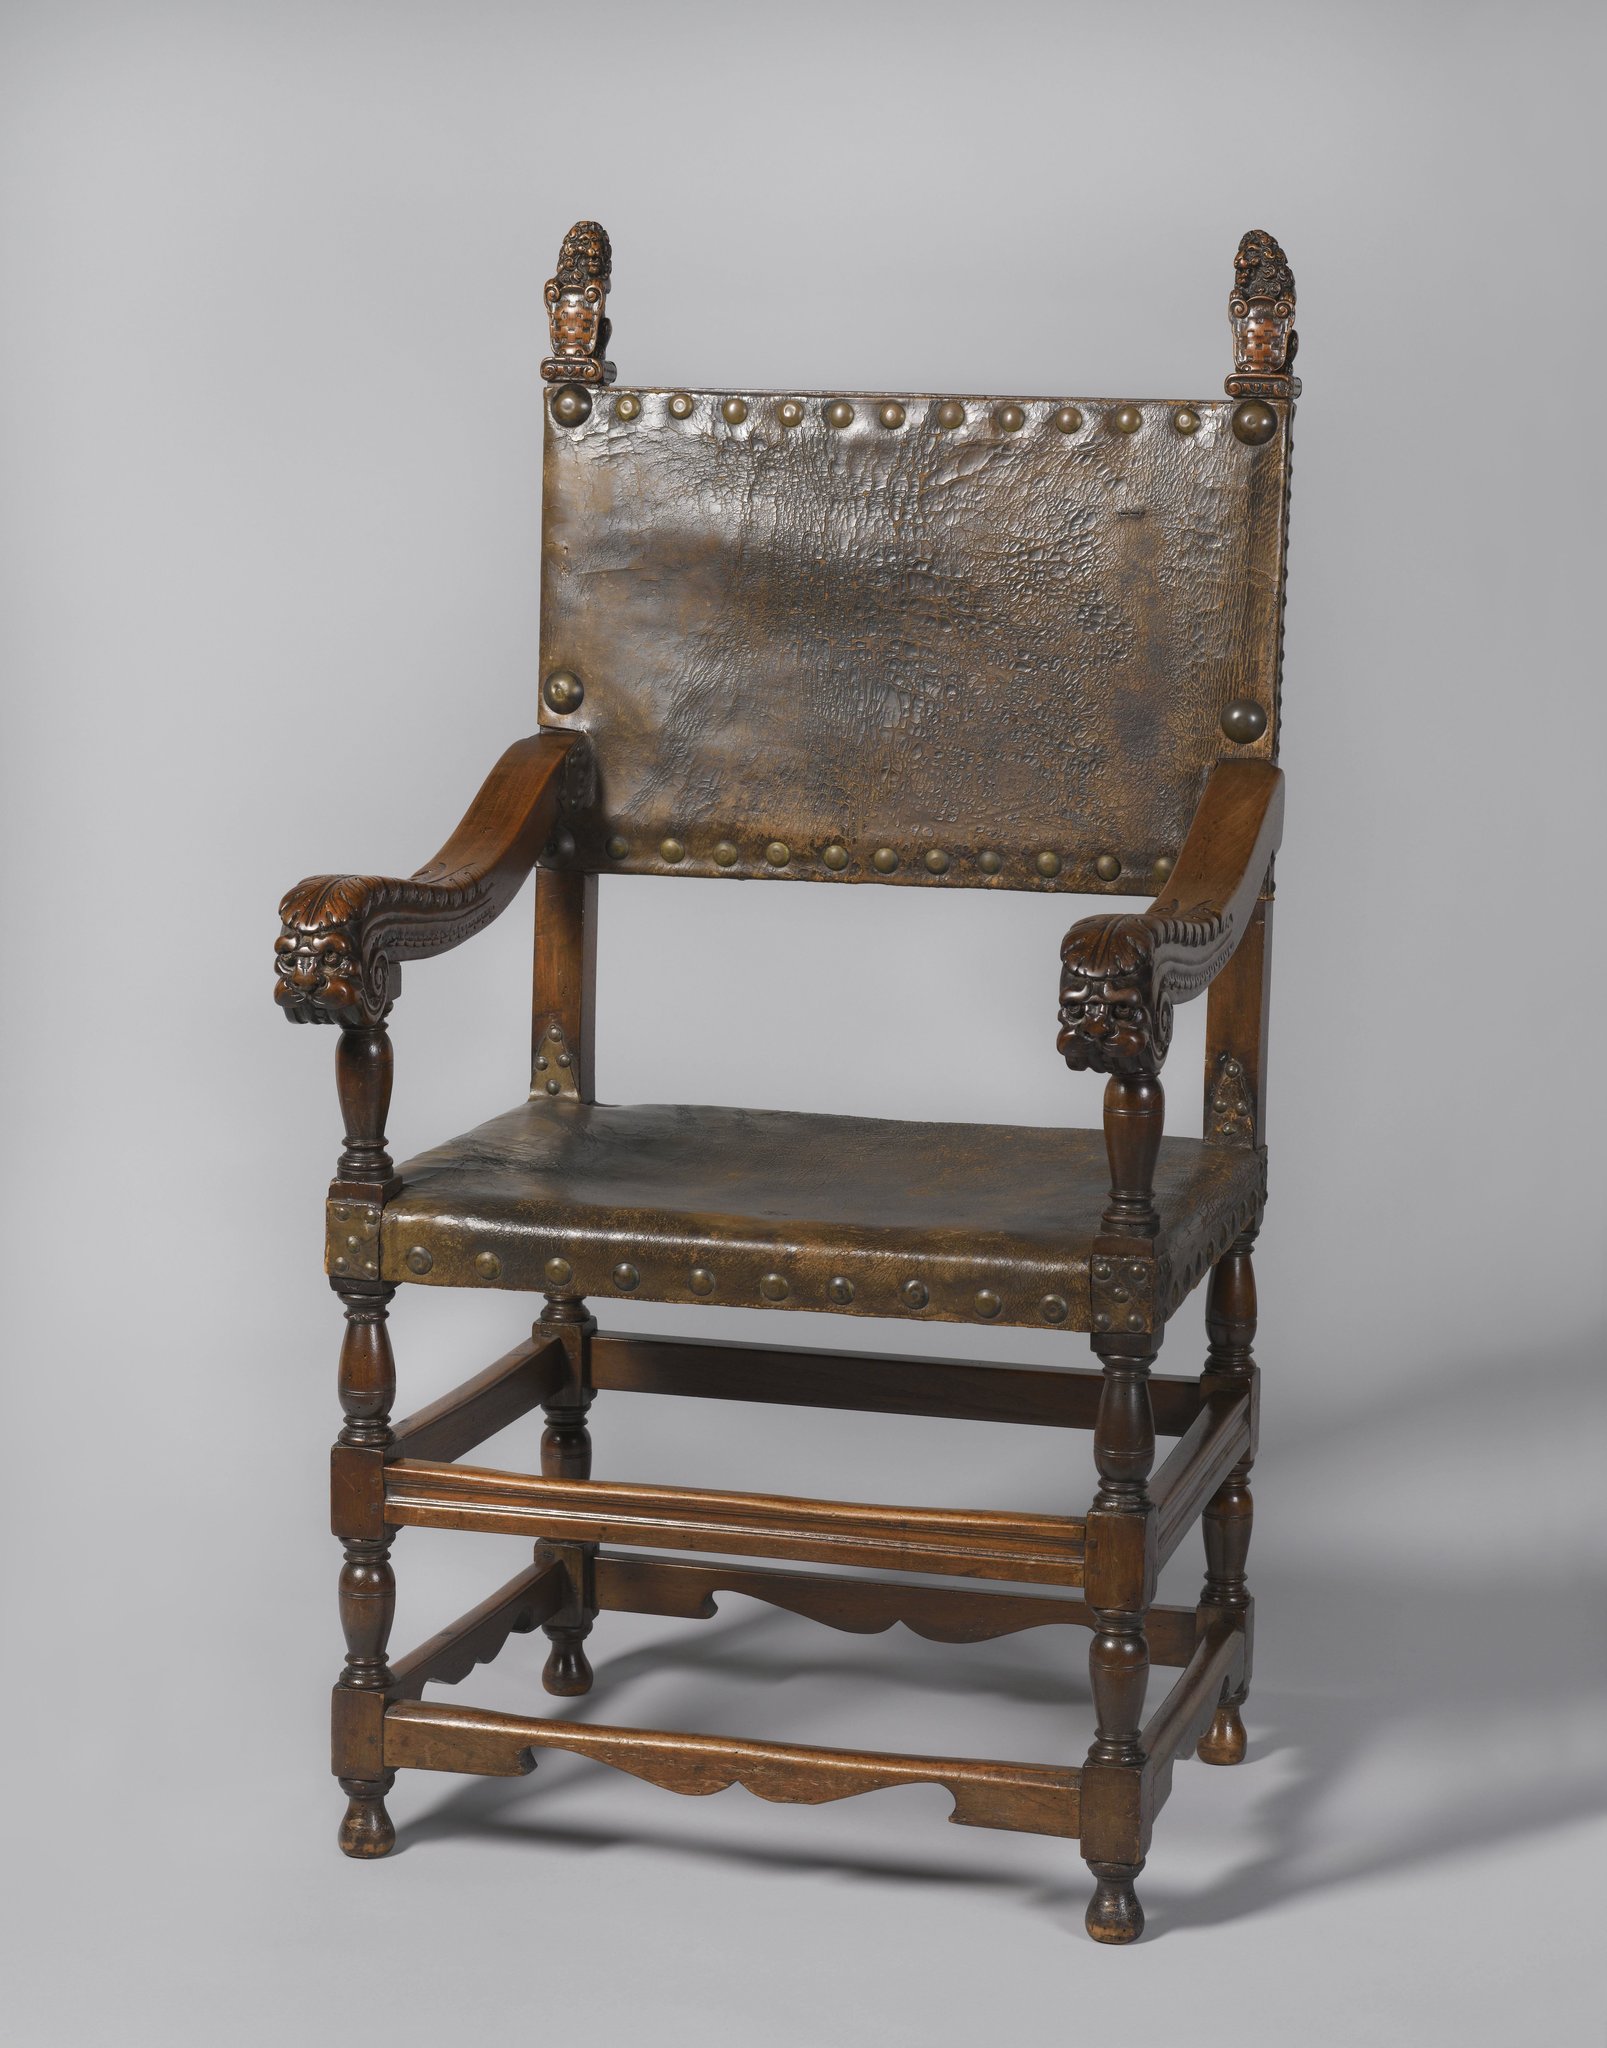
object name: furniture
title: Armstoel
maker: Anonymous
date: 1600-1625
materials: leather, wood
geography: northern netherlands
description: Armchair. Walnut, Netherlands, c. 1600 - 1625.